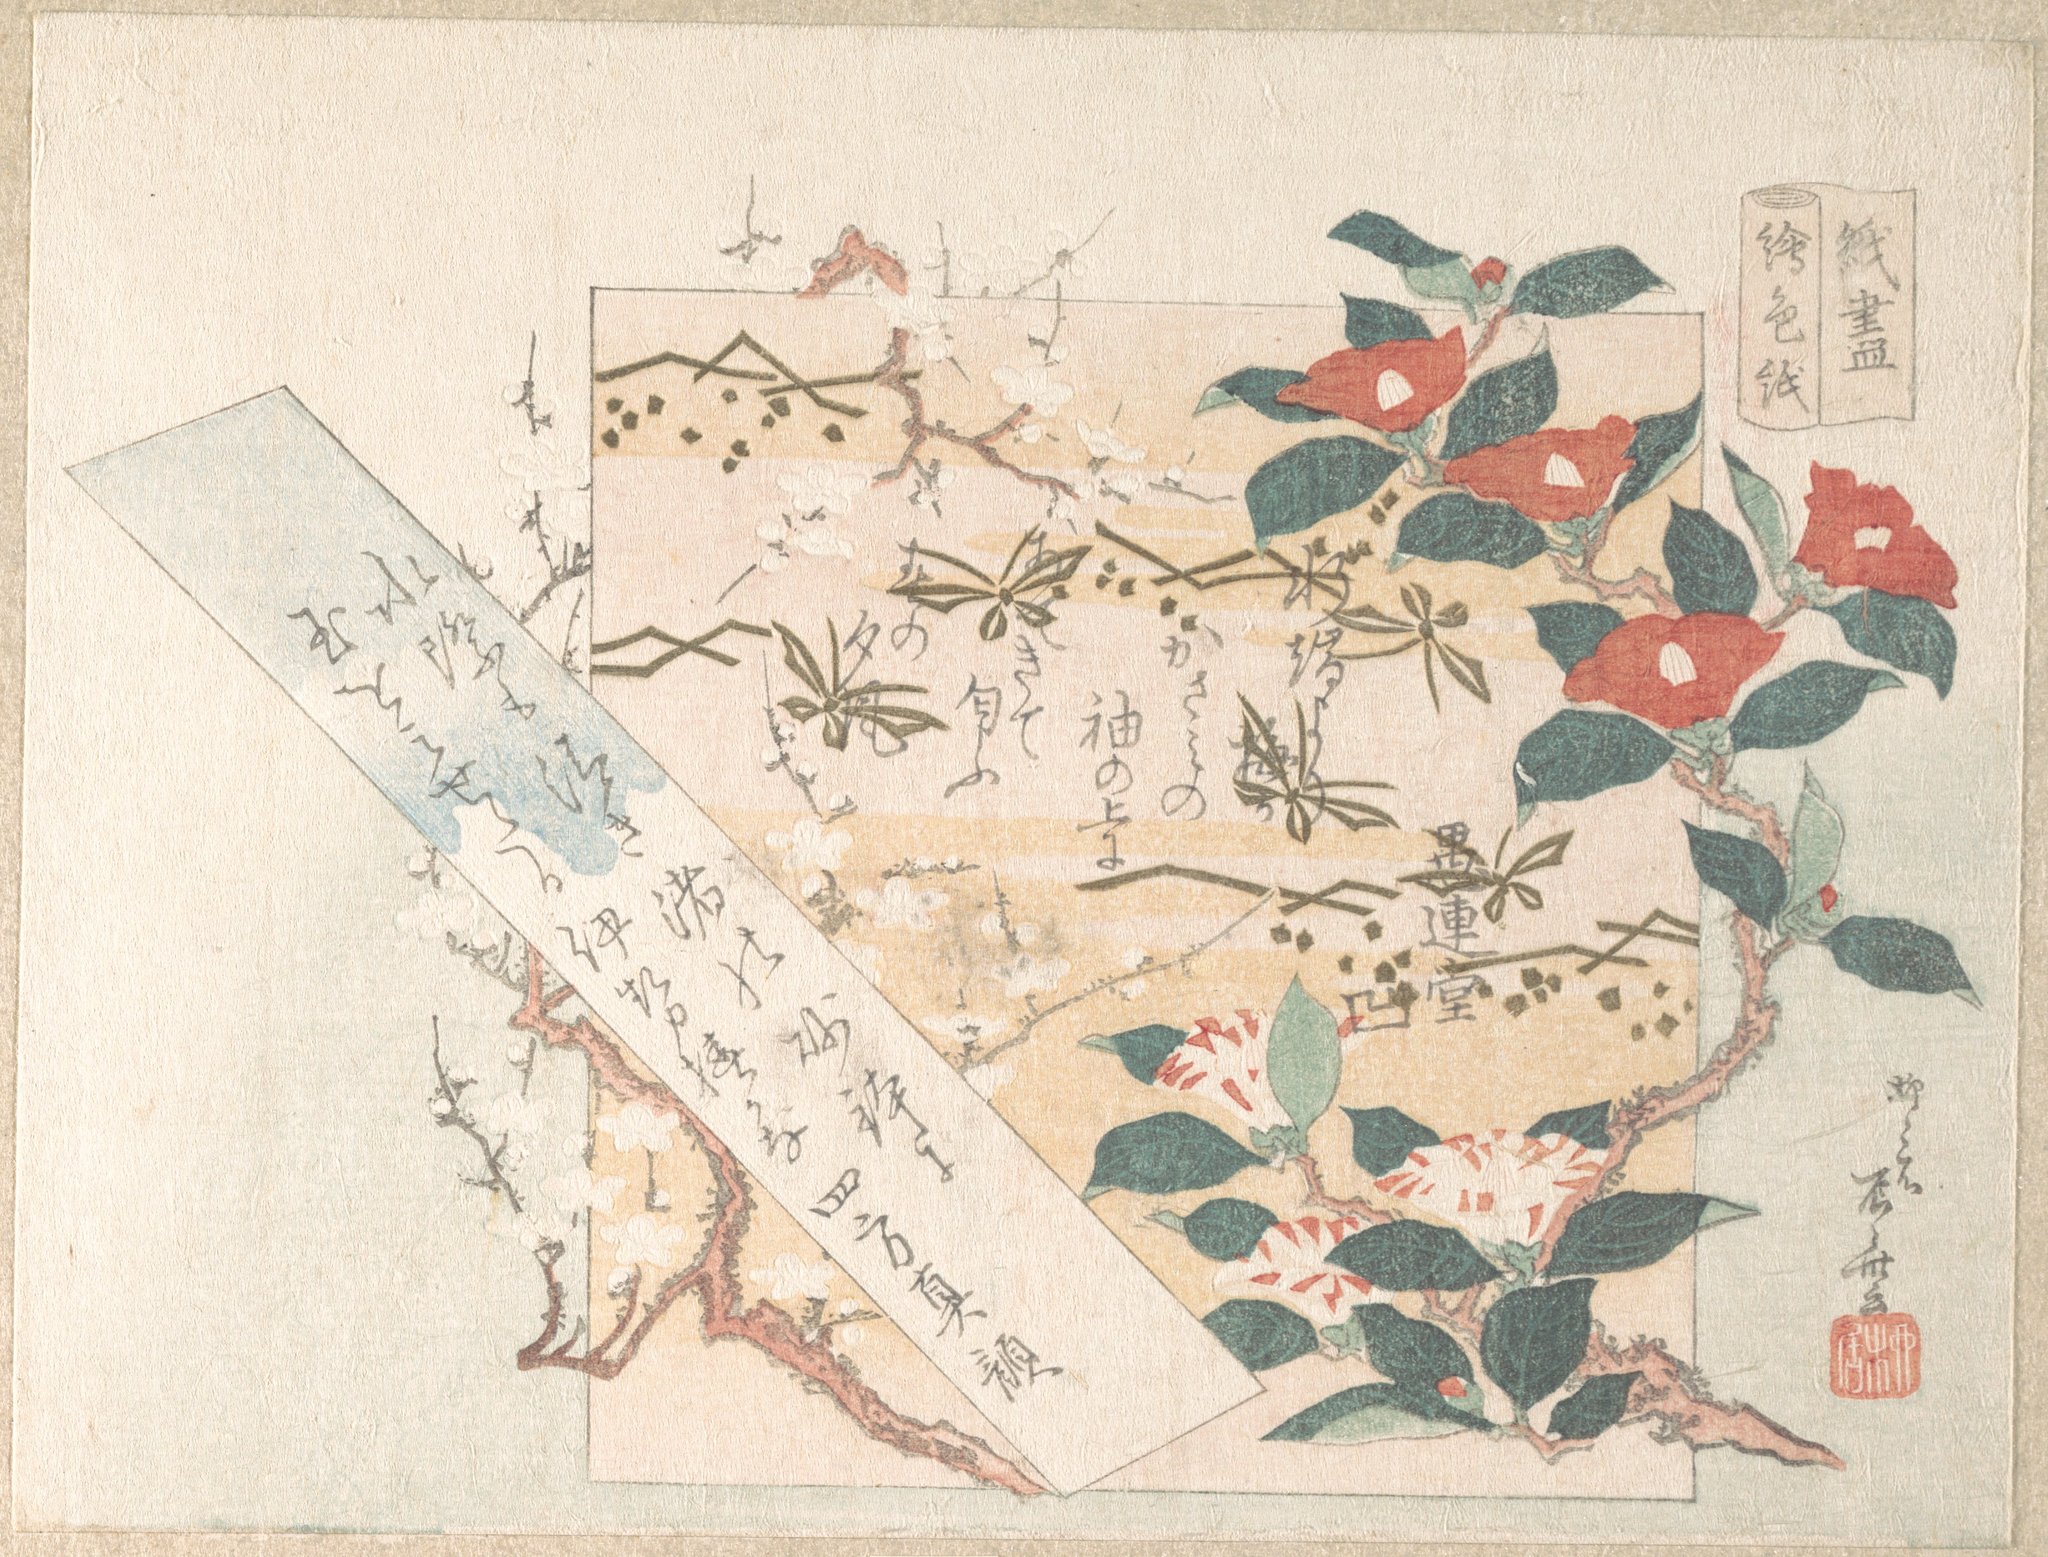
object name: print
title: Designs of Writing-Paper with Flowers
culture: japanese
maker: ryūryūkyo shinsai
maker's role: artist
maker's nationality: japanese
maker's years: 1799-1823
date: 1801-1900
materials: ink, paper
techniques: surimono, woodblock print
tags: flowers,leaves